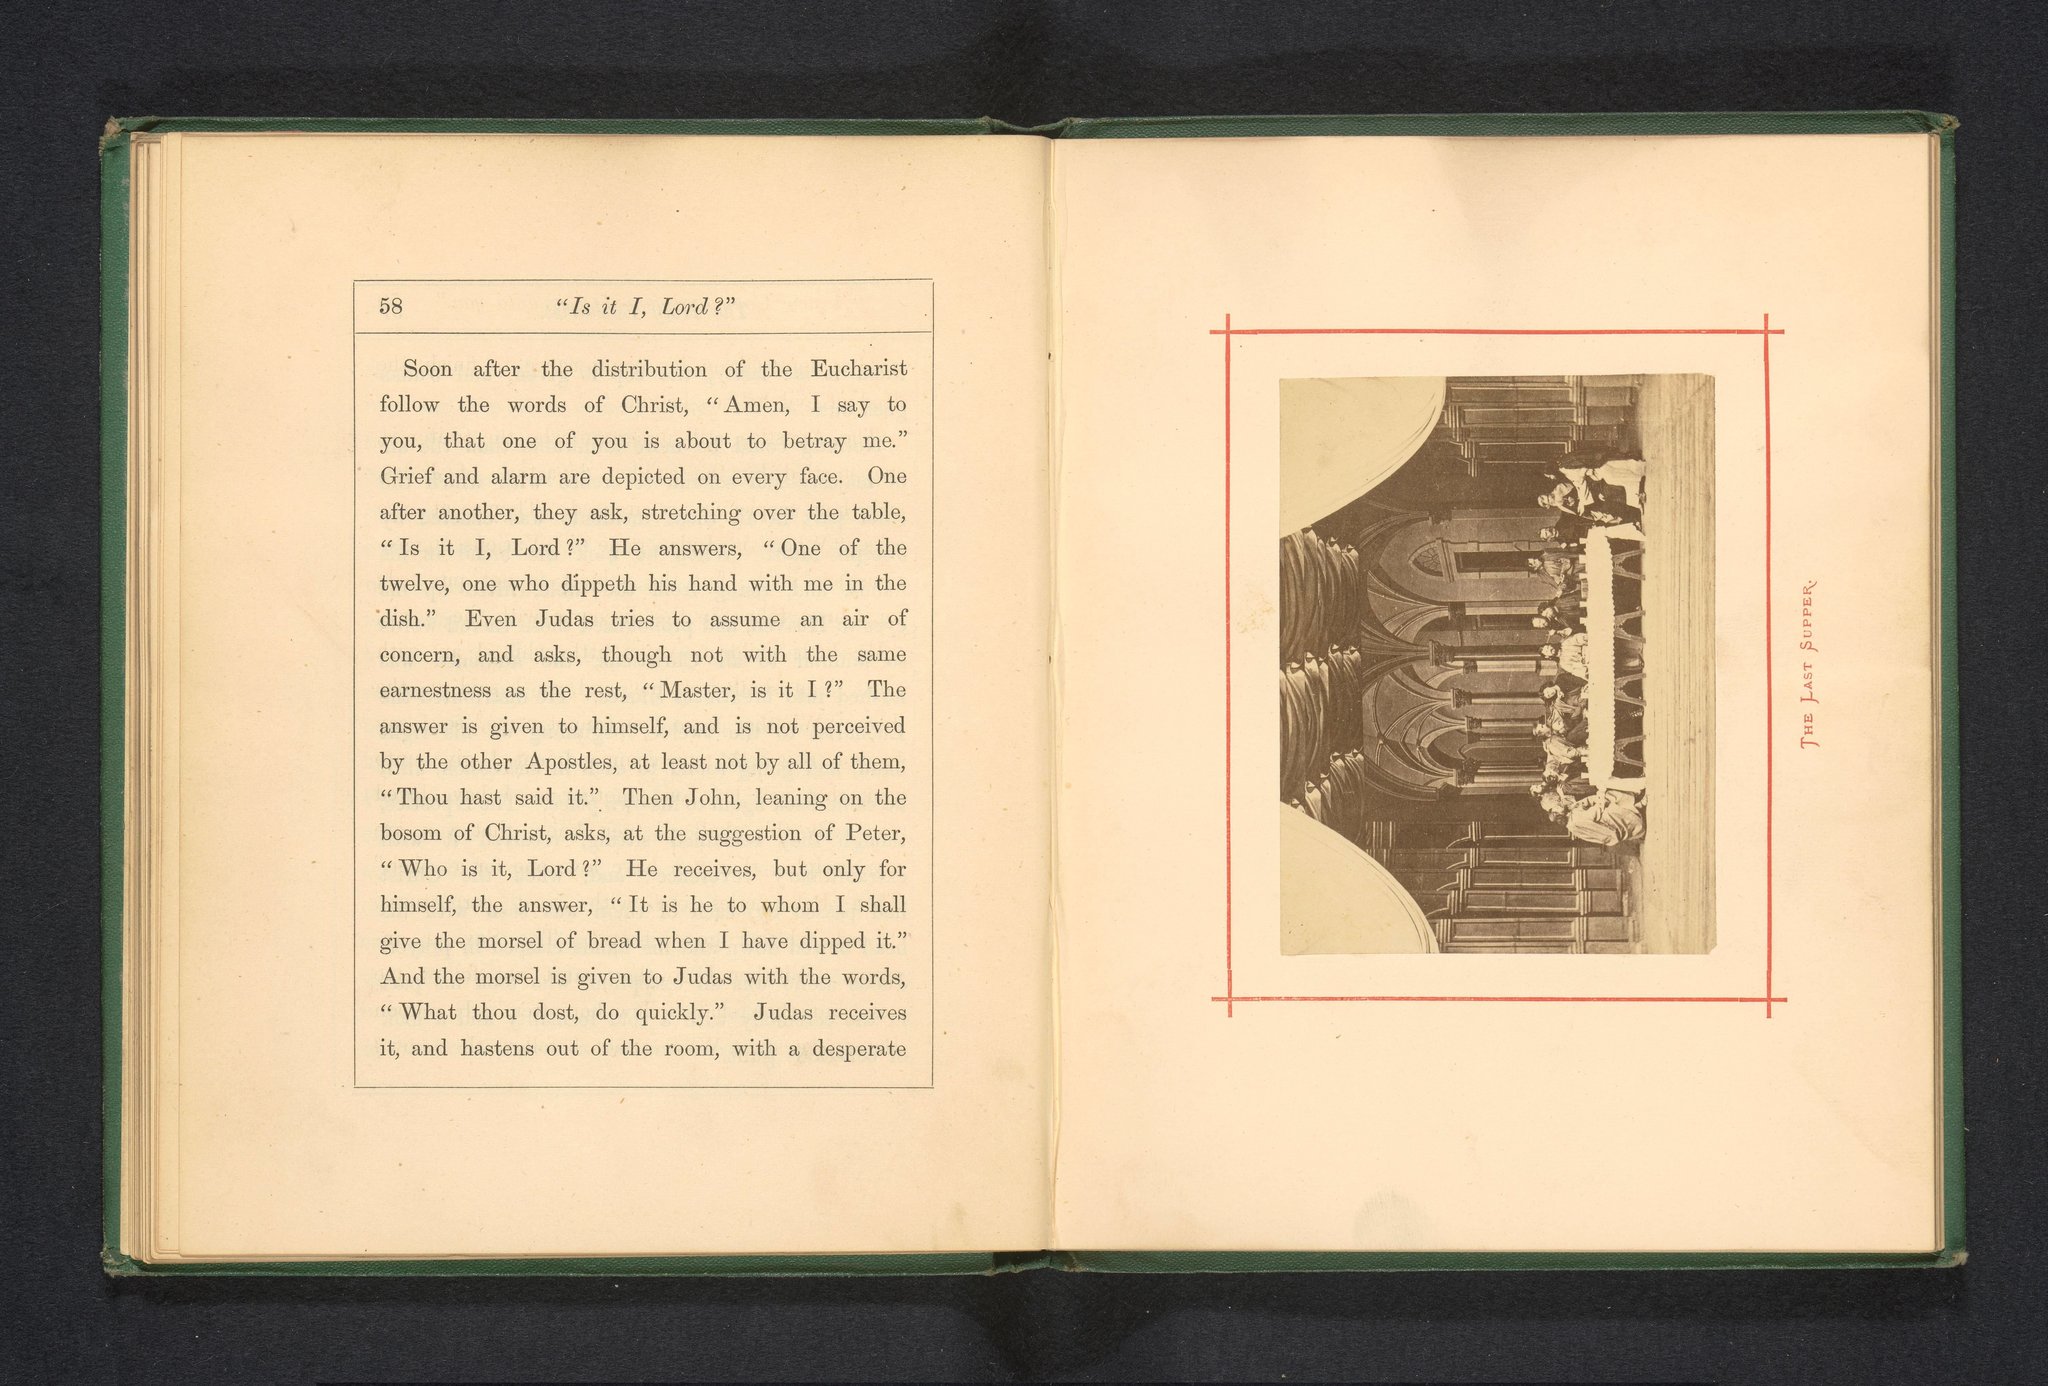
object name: page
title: The Last Supper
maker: joseph albert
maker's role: printer, publisher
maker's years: 1825-1886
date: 1867-1872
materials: photographic support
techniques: albumen print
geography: oberammergau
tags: the episode of the last supper, group of actors, troupe; actors on the stage, oberammergau